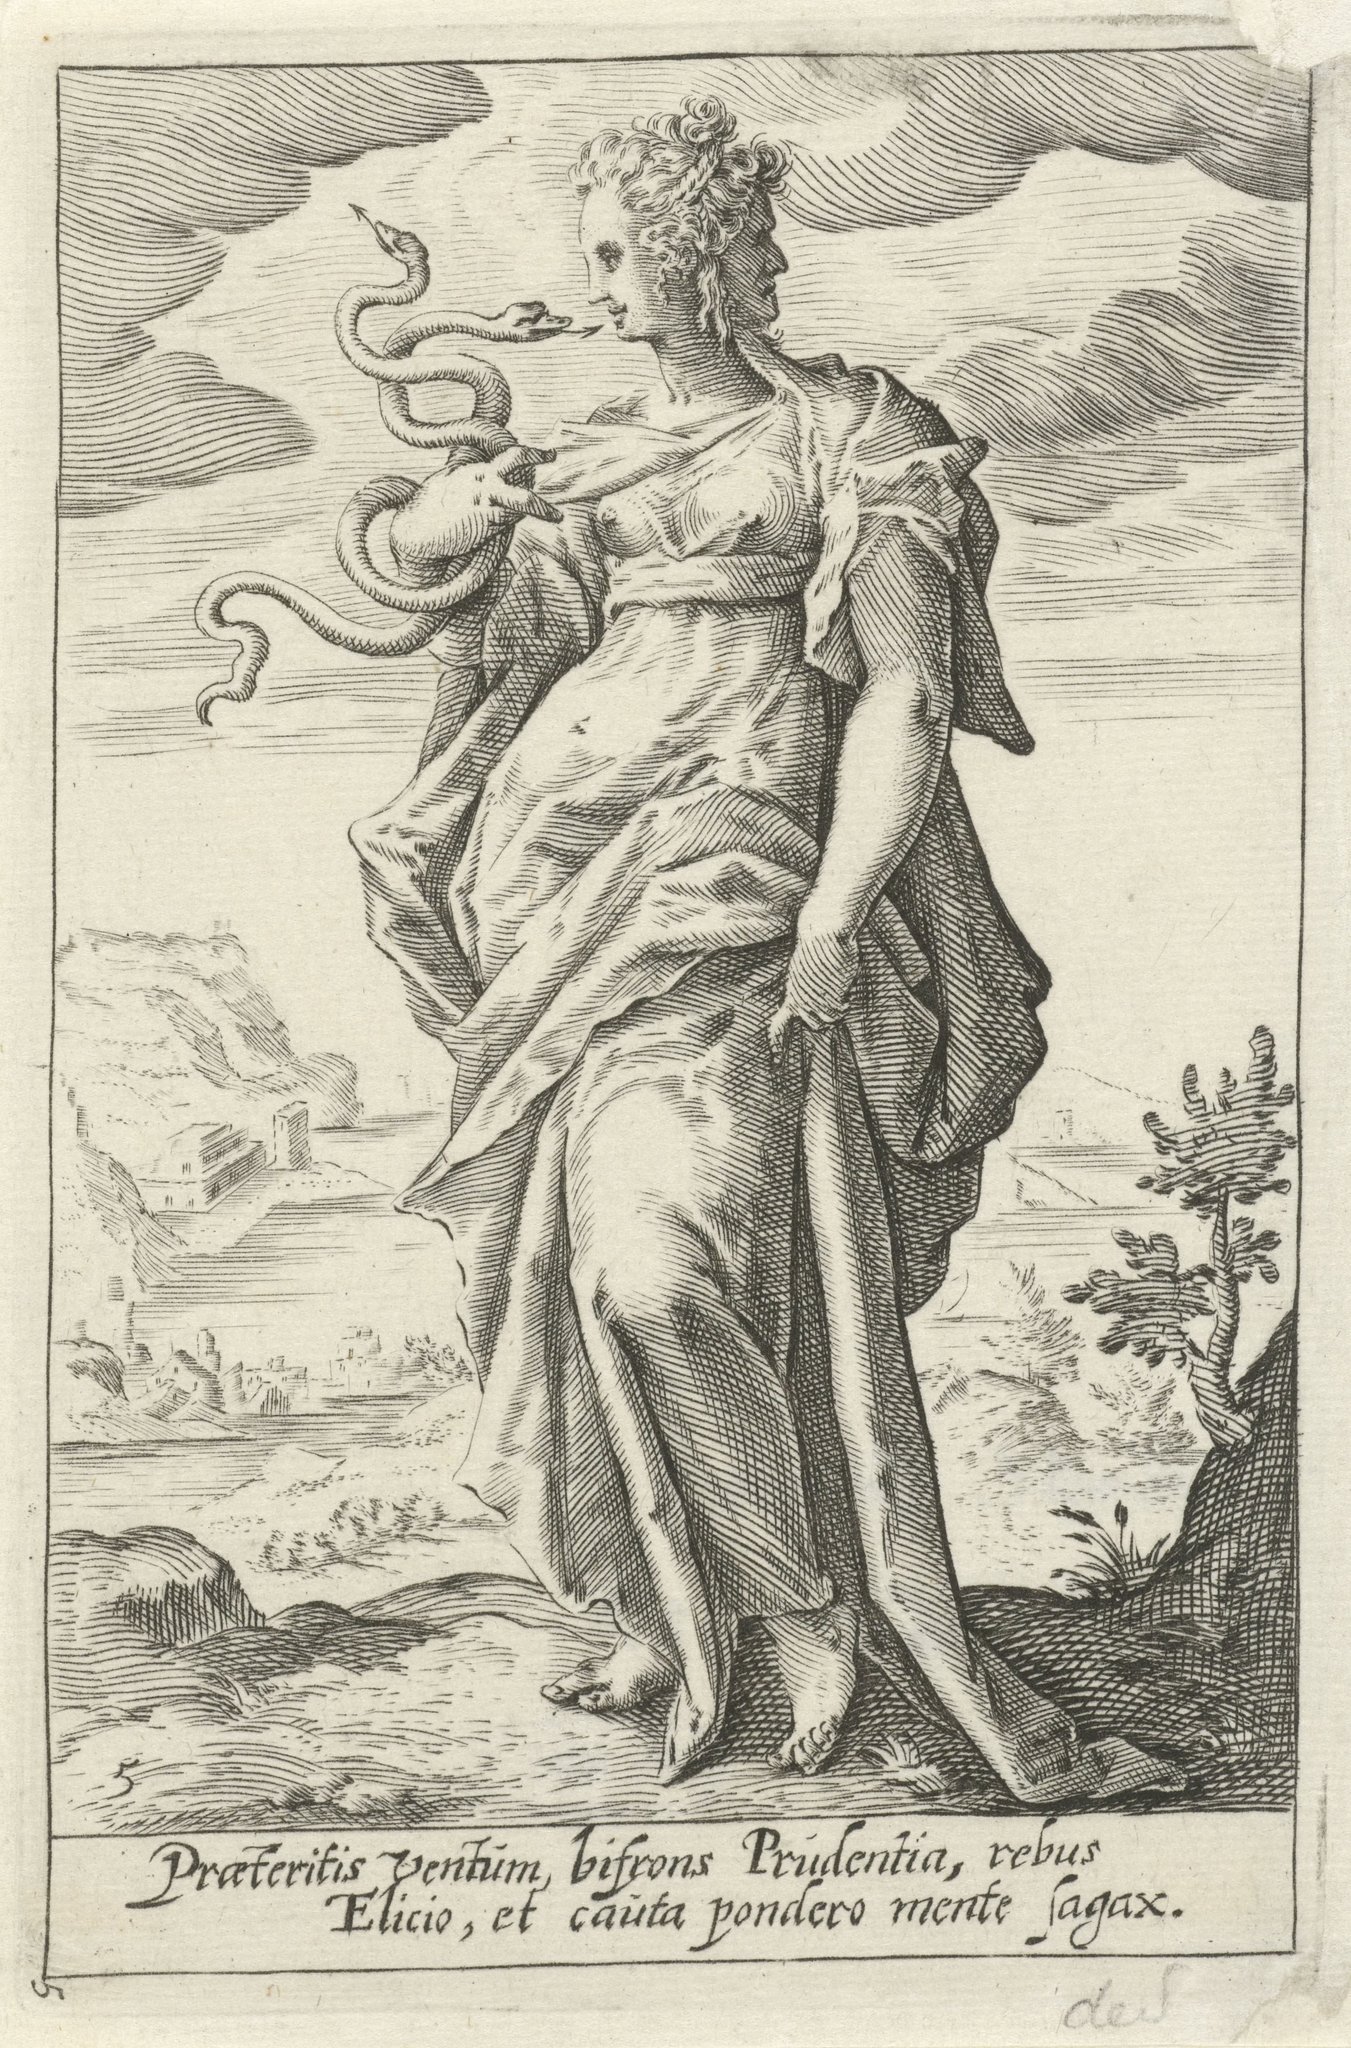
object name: print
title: Voorzichtigheid (Prudentia)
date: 1601-1652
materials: paper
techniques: engraving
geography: amsterdam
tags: prudence, 'prudentia'; 'prudenza' (ripa) ~ one of the four cardinal virtues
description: De gepersonifieerde Voorzichtigheid; een vrouwenfiguur met twee slangen in haar hand en een tweede gezicht op haar achterhoofd.